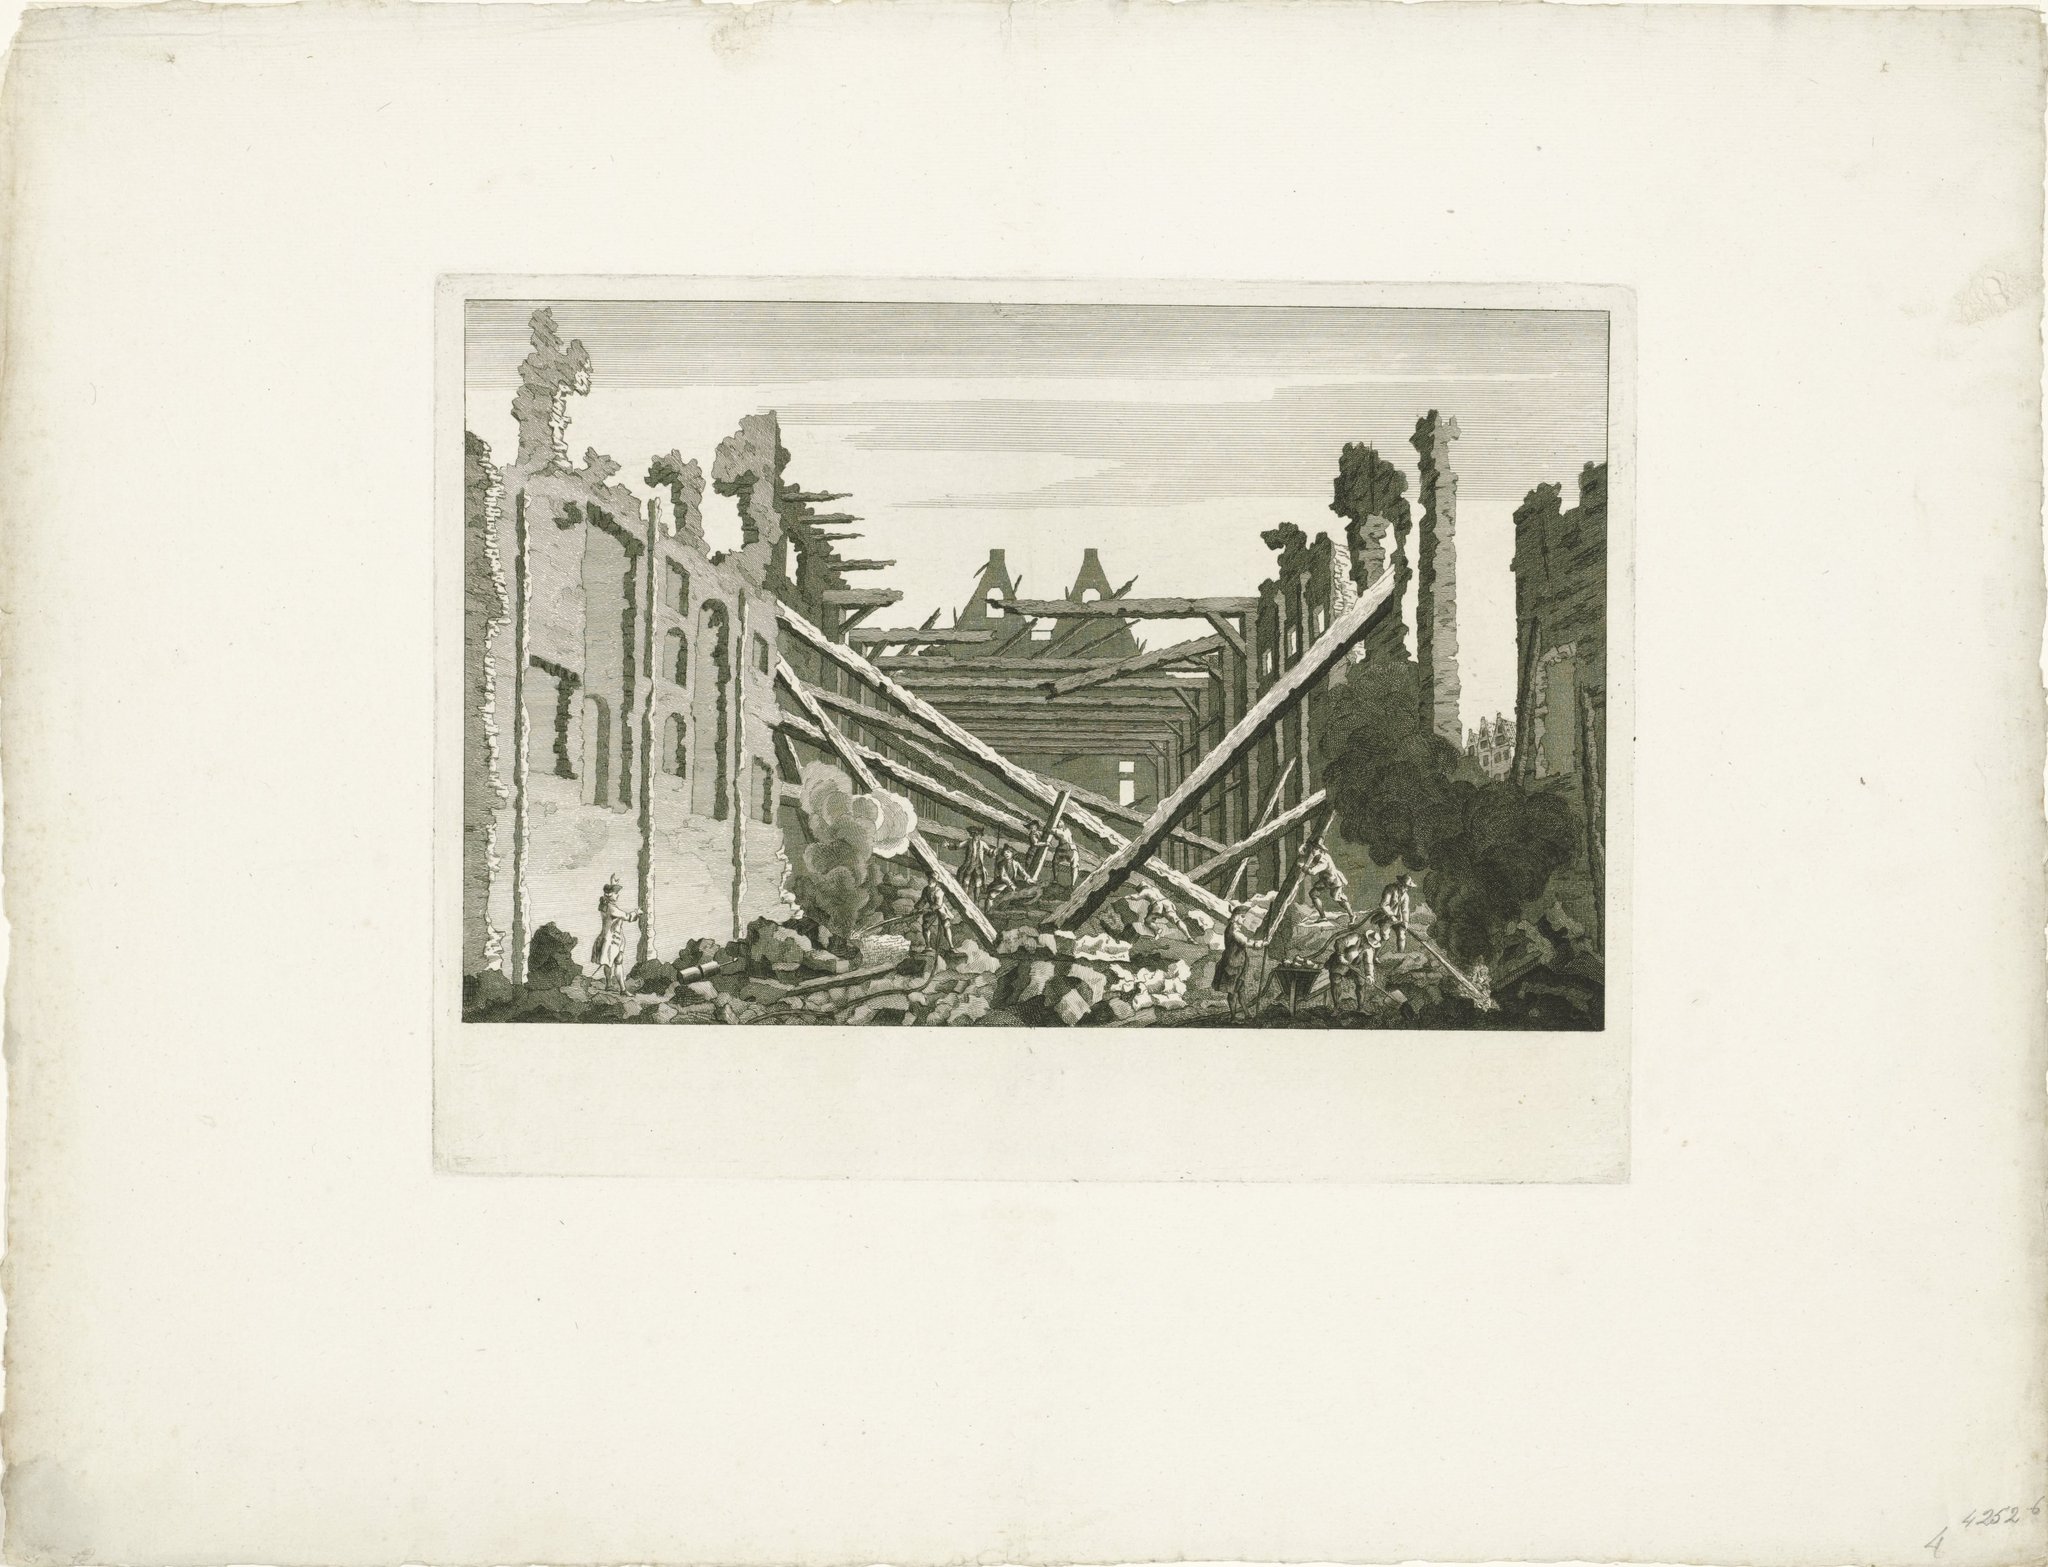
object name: print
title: Ruïne van de afgebrande schouwburg aan de Keizersgracht te Amsterdam, 1772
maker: cornelis bogerts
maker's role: print maker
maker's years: 1745-1817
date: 1772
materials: paper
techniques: engraving, etching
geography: northern netherlands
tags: on fire, ablaze, theatre, theatrical performance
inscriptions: collector's mark: Lugt 2228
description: Gezicht op de ruïne van de Amsterdamse Schouwburg na de brand van 11 mei 1772. Onderdeel van een serie van vier prenten met titelprent over de brand in de Amsterdamse Schouwburg.